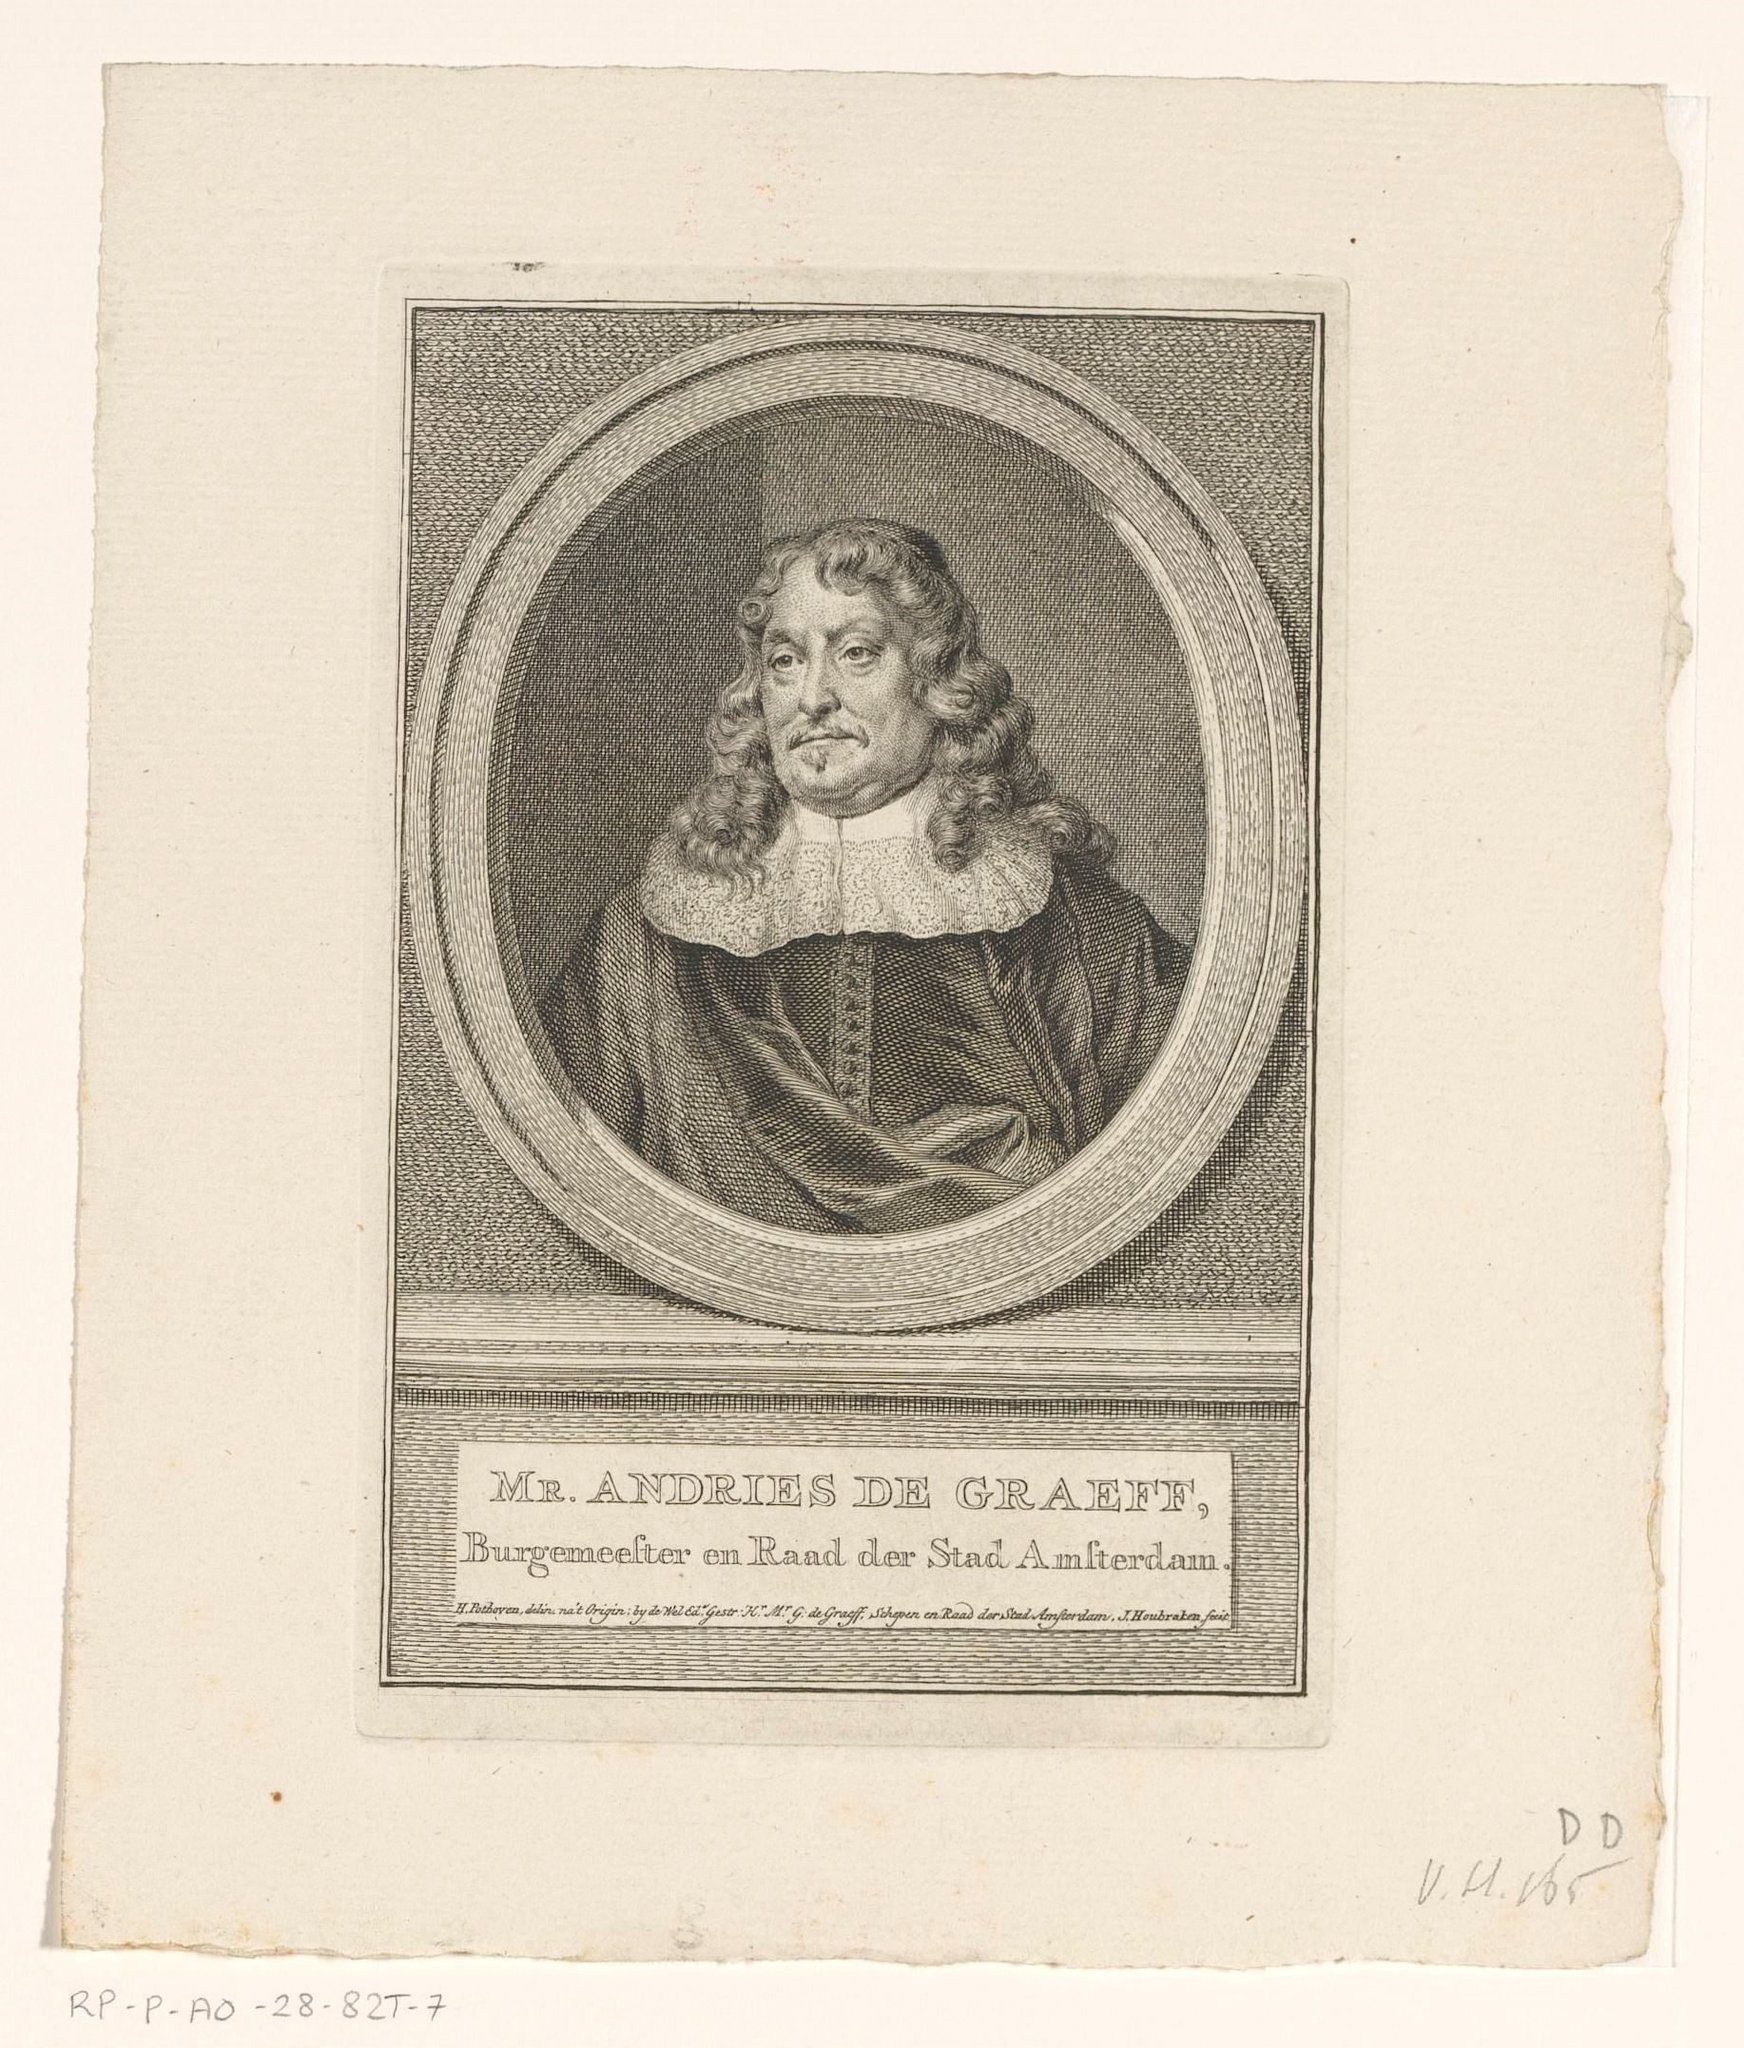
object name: print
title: Portret van Andries de Graeff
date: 1749-1780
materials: paper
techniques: engraving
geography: amsterdam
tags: amsterdam, mayor, historical persons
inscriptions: collector's mark: Lugt 2228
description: Deze prent is oorspronkelijk bedoeld als aanvulling op Jan Wagenaars ‘Vaderlandsche historie’* en was zo vanaf 1796 verkrijgbaar bij Johannes Allart te Amsterdam. Voor de advertentie waarin Allart de 60 portretten en 7 platen, allen gegraveerd door Houbraken, ter aanvulling op Wagenaars ‘Vaderlandsche historie’ aanbiedt, zie RP-P-OB-77.766. *Van dit werk zijn in de achttiende eeuw meerdere uitgaves verschenen, zoals: Wagenaar, Jan. Vaderlandsche historie, vervattende de geschiedenissen der Vereenigde Nederlanden (…). 21 delen. Amsterdam: Isaak Tirion, 1749-1759. Wagenaar, Jan. Vaderlandsche historie, vervattende de geschiedenissen der nu Vereenigde Nederlanden (…). 21 delen. Amsterdam: weduwe Isaak Tirion, 1770. Wagenaar, Jan. Vaderlandsche historie, vervattende de geschiedenissen der nu Vereenigde Nederlanden (…). 21 delen. Amsterdam, Leiden, Dordrecht en Harlingen: P. Schouten e.a., 1782. Wagenaar, Jan. Vaderlandsche historie, vervattende de geschiedenissen der nu Vereenigde Nederlanden (…). 21 delen. Amsterdam: Johannes Allart, 1790-1796.